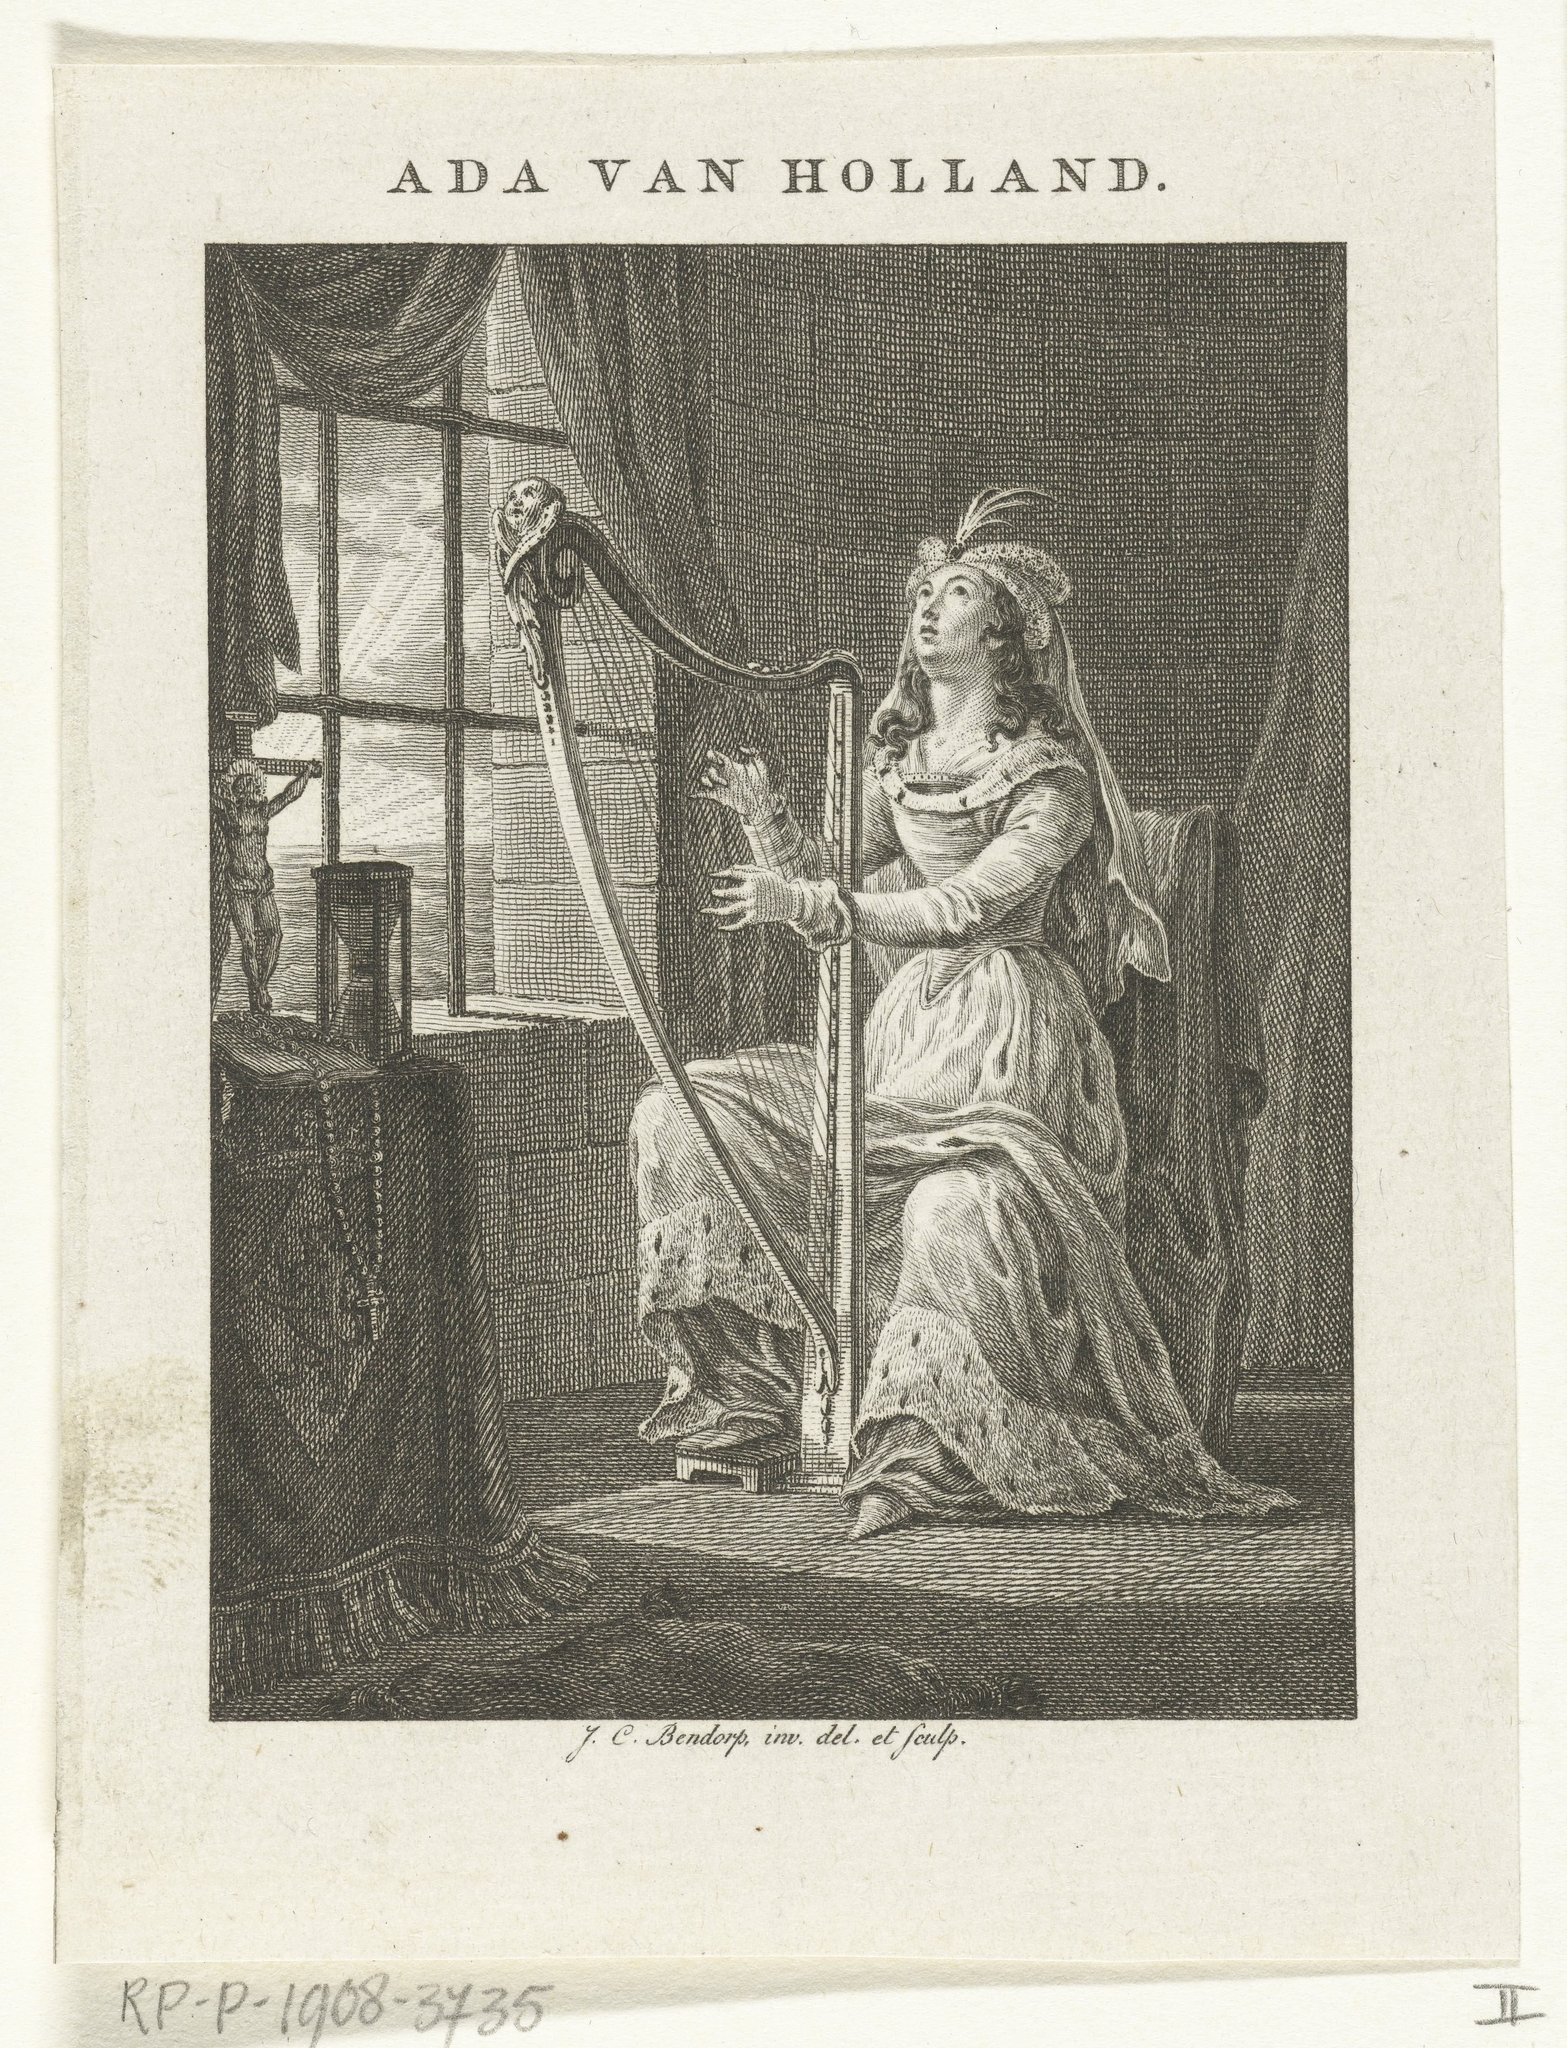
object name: print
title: Ada gravin van Holland speelt op harp tijdens gevangenschap op Texel in 1203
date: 1776-1824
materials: paper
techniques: etching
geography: netherlands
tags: harp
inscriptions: collector's mark: Lugt 2228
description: Prent uit: Nederlandsche muzen-almanak, Johannes Immerzeel (uitgever), Rotterdam 1824. Illustratie bij gedicht van A.C.W. Staring, Ada van Holland waarin de gravin aan het woord is en met weemoed terug denkt aan haar jeugd en nu verlangt naar de dood.